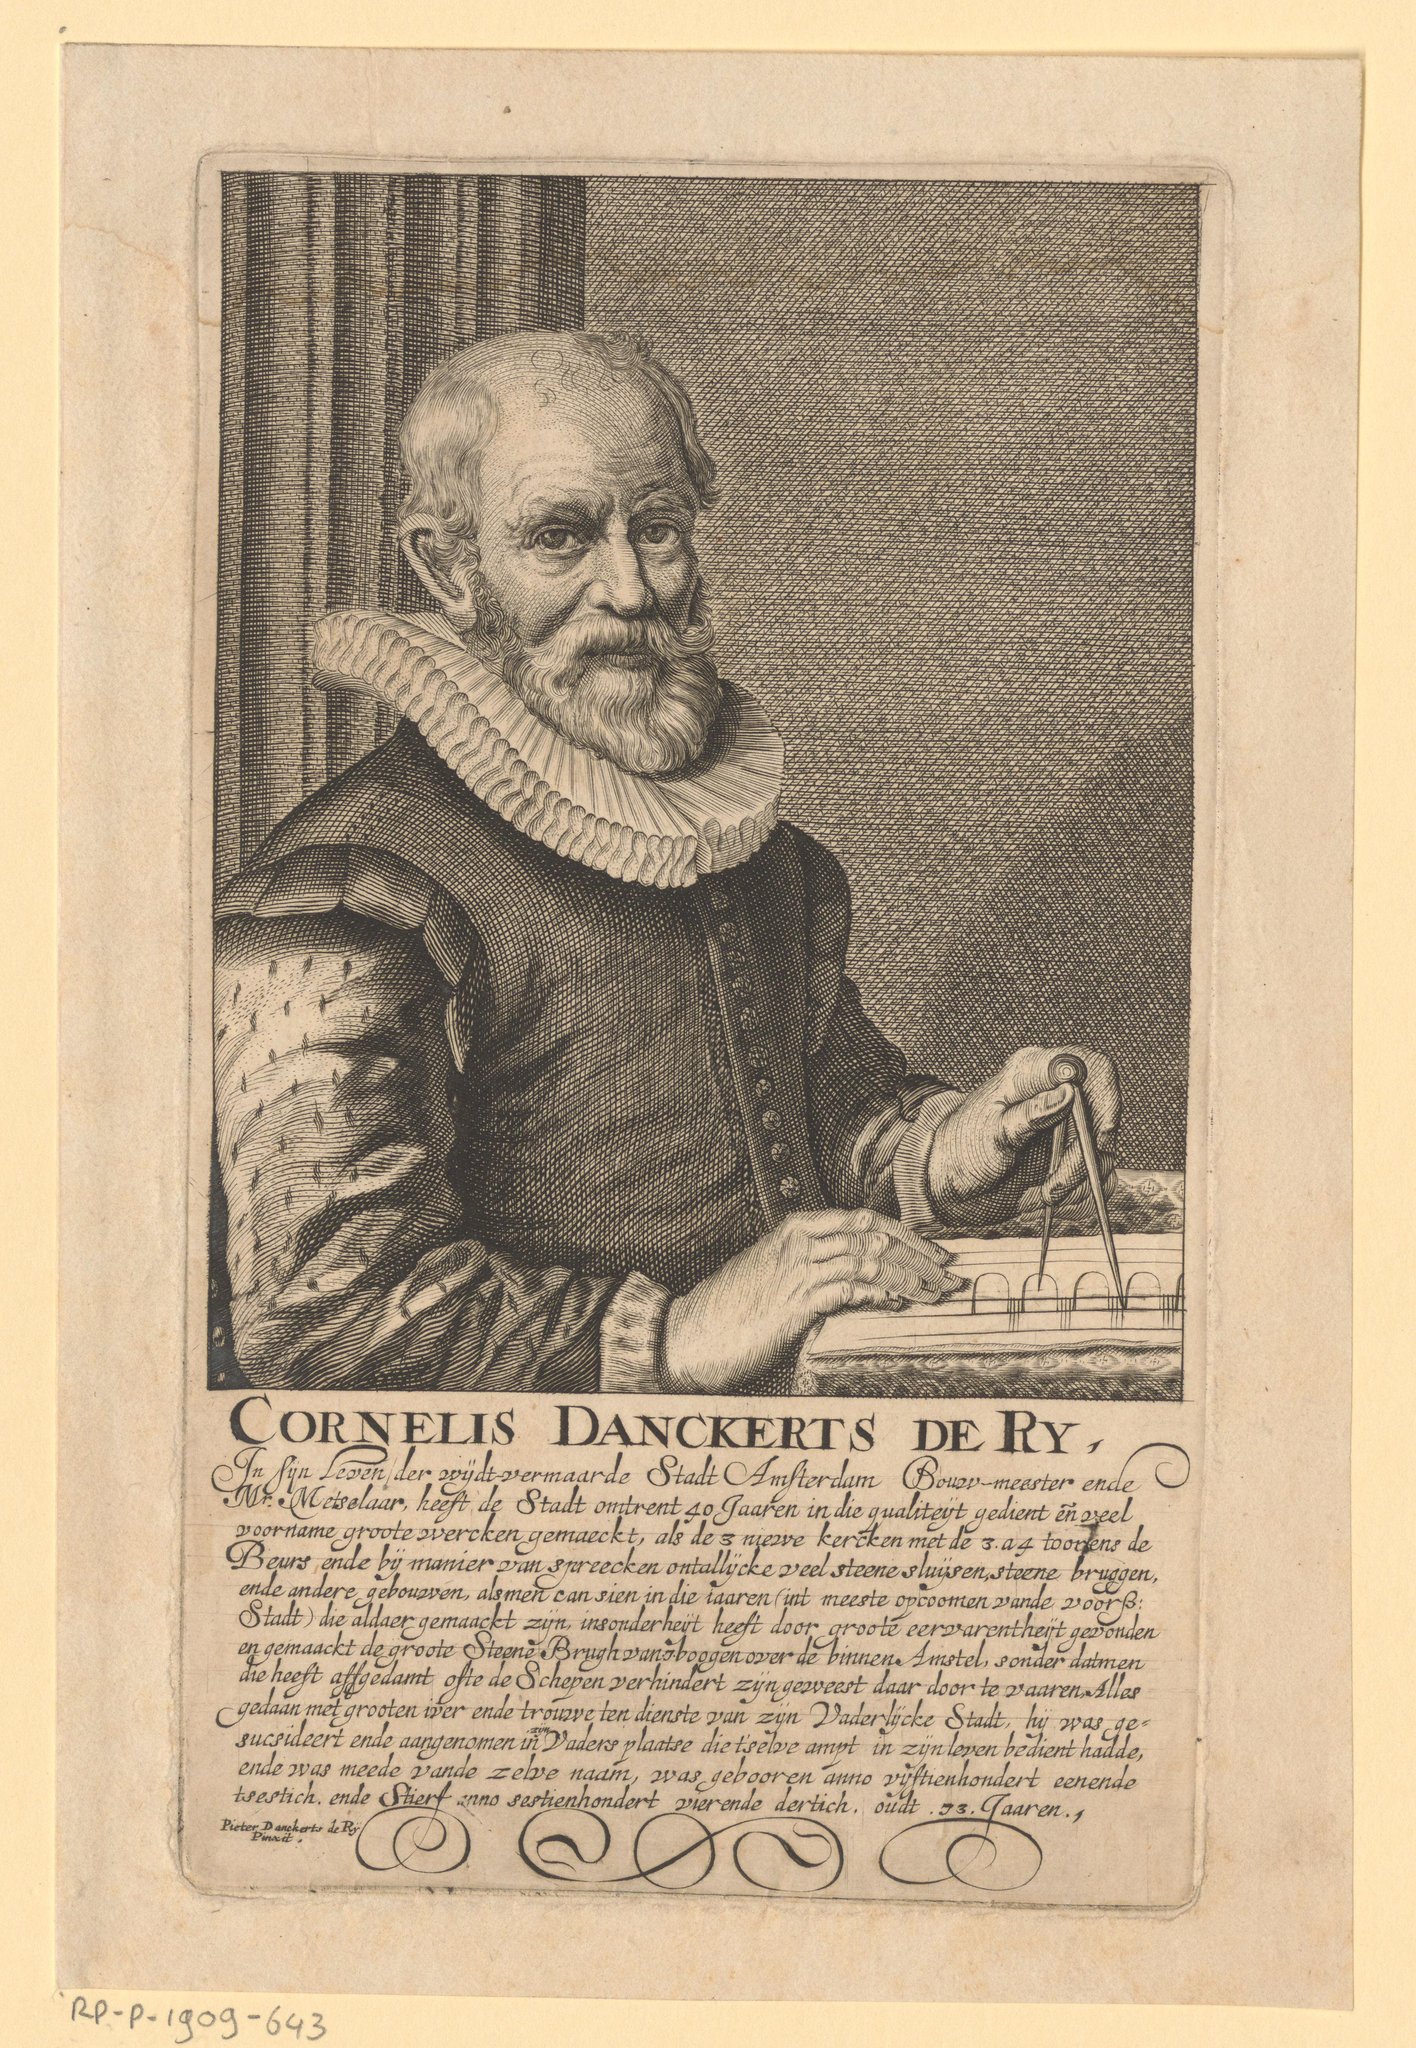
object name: print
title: Portret van Cornelis Danckerts de Ry op 73-jarige leeftijd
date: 1634-1699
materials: paper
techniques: engraving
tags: historical persons, compasses, portrait, self-portrait of architect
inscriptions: collector's mark: Lugt 2228